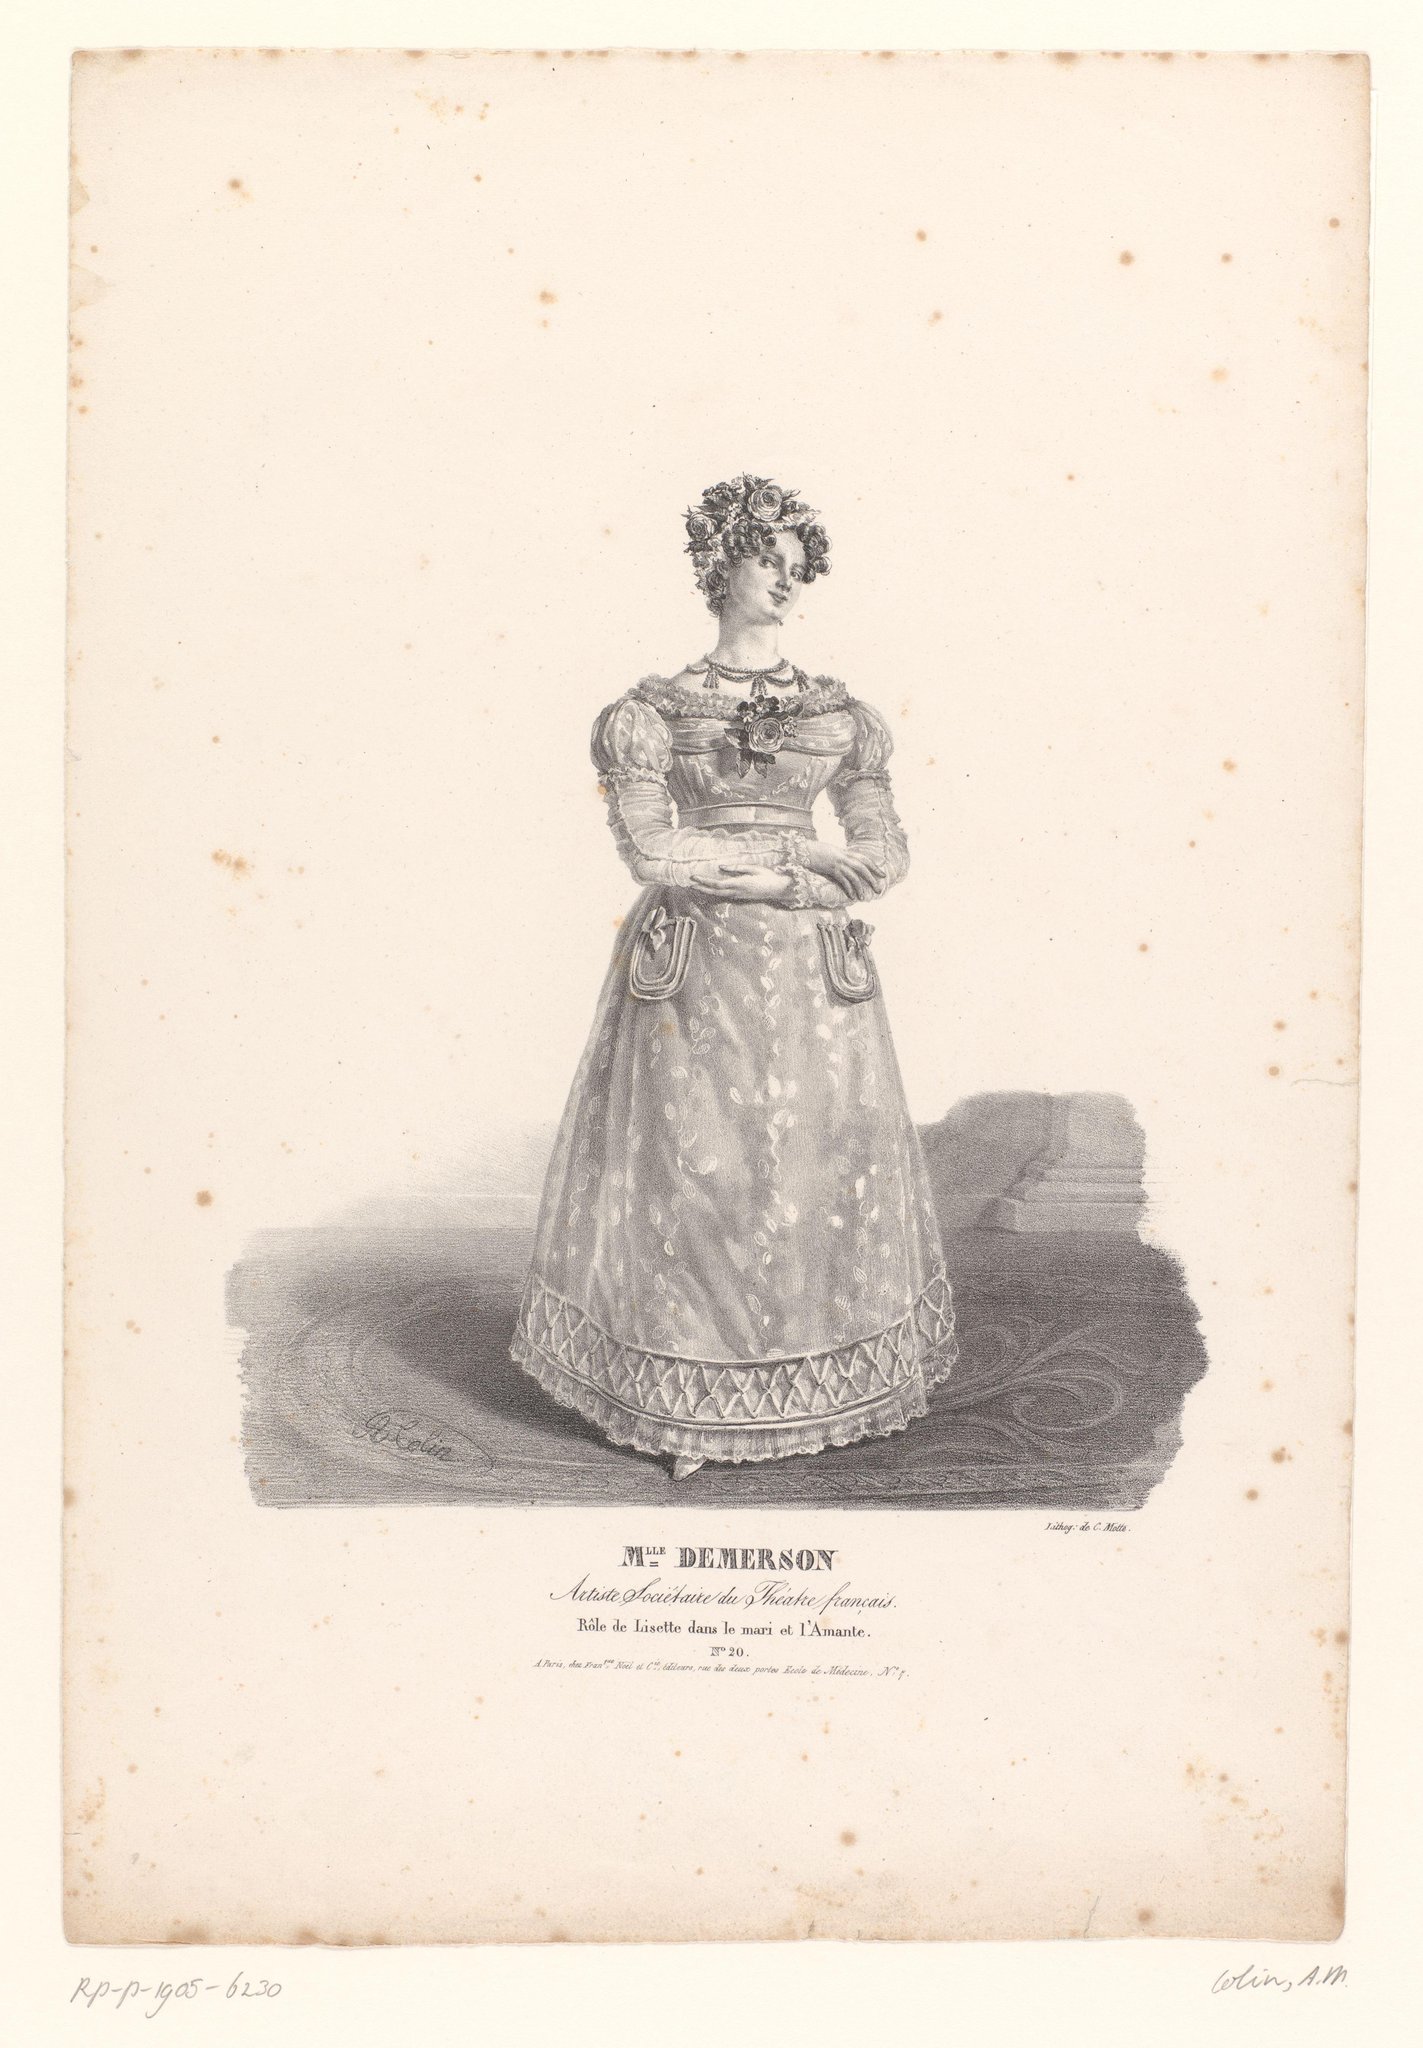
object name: print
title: Portretten van acteurs van Parijse theaters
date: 1823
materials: paper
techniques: lithograph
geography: paris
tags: stage costume, portrait of actor, actress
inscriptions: collector's mark: Lugt 2228a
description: Lisette is een personage uit de komedie 'Le Mari et l'Amant' van Jean-Claude Vial. Opgevoerd door het Théâtre Français in 1821.